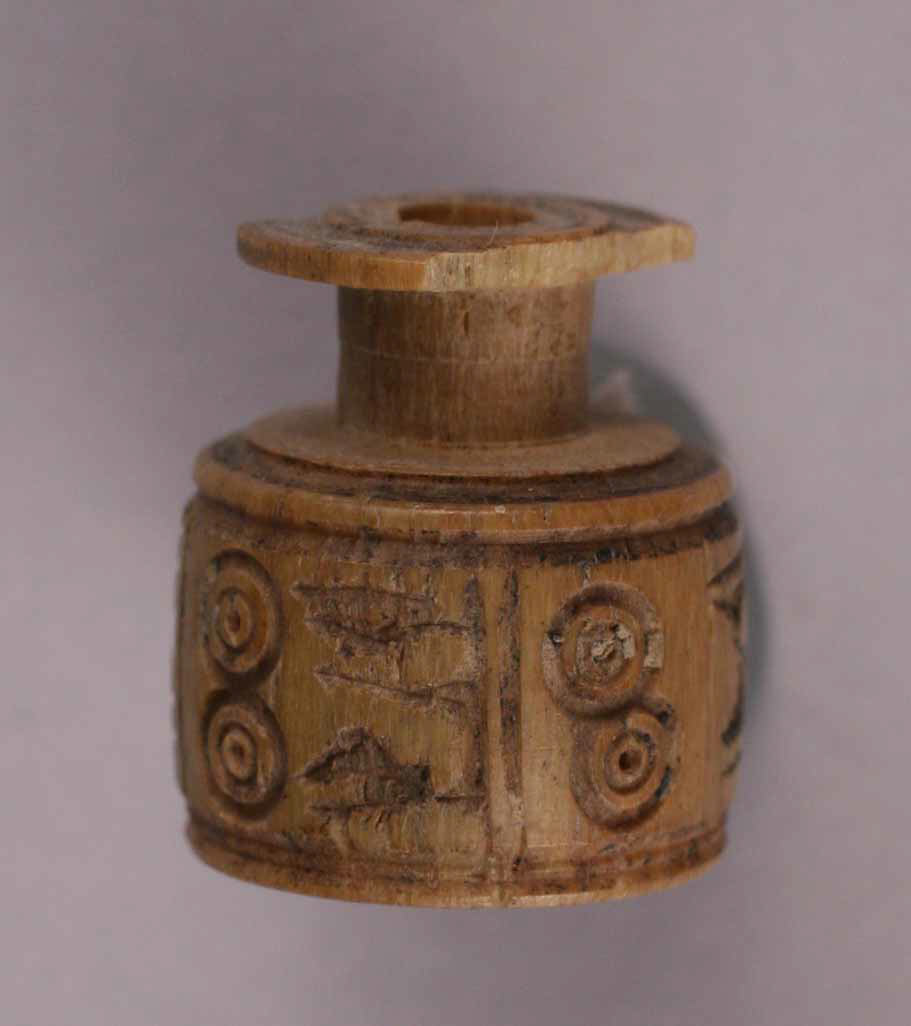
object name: bead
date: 801-1000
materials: bone, ivory, paint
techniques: incising, inlay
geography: iran